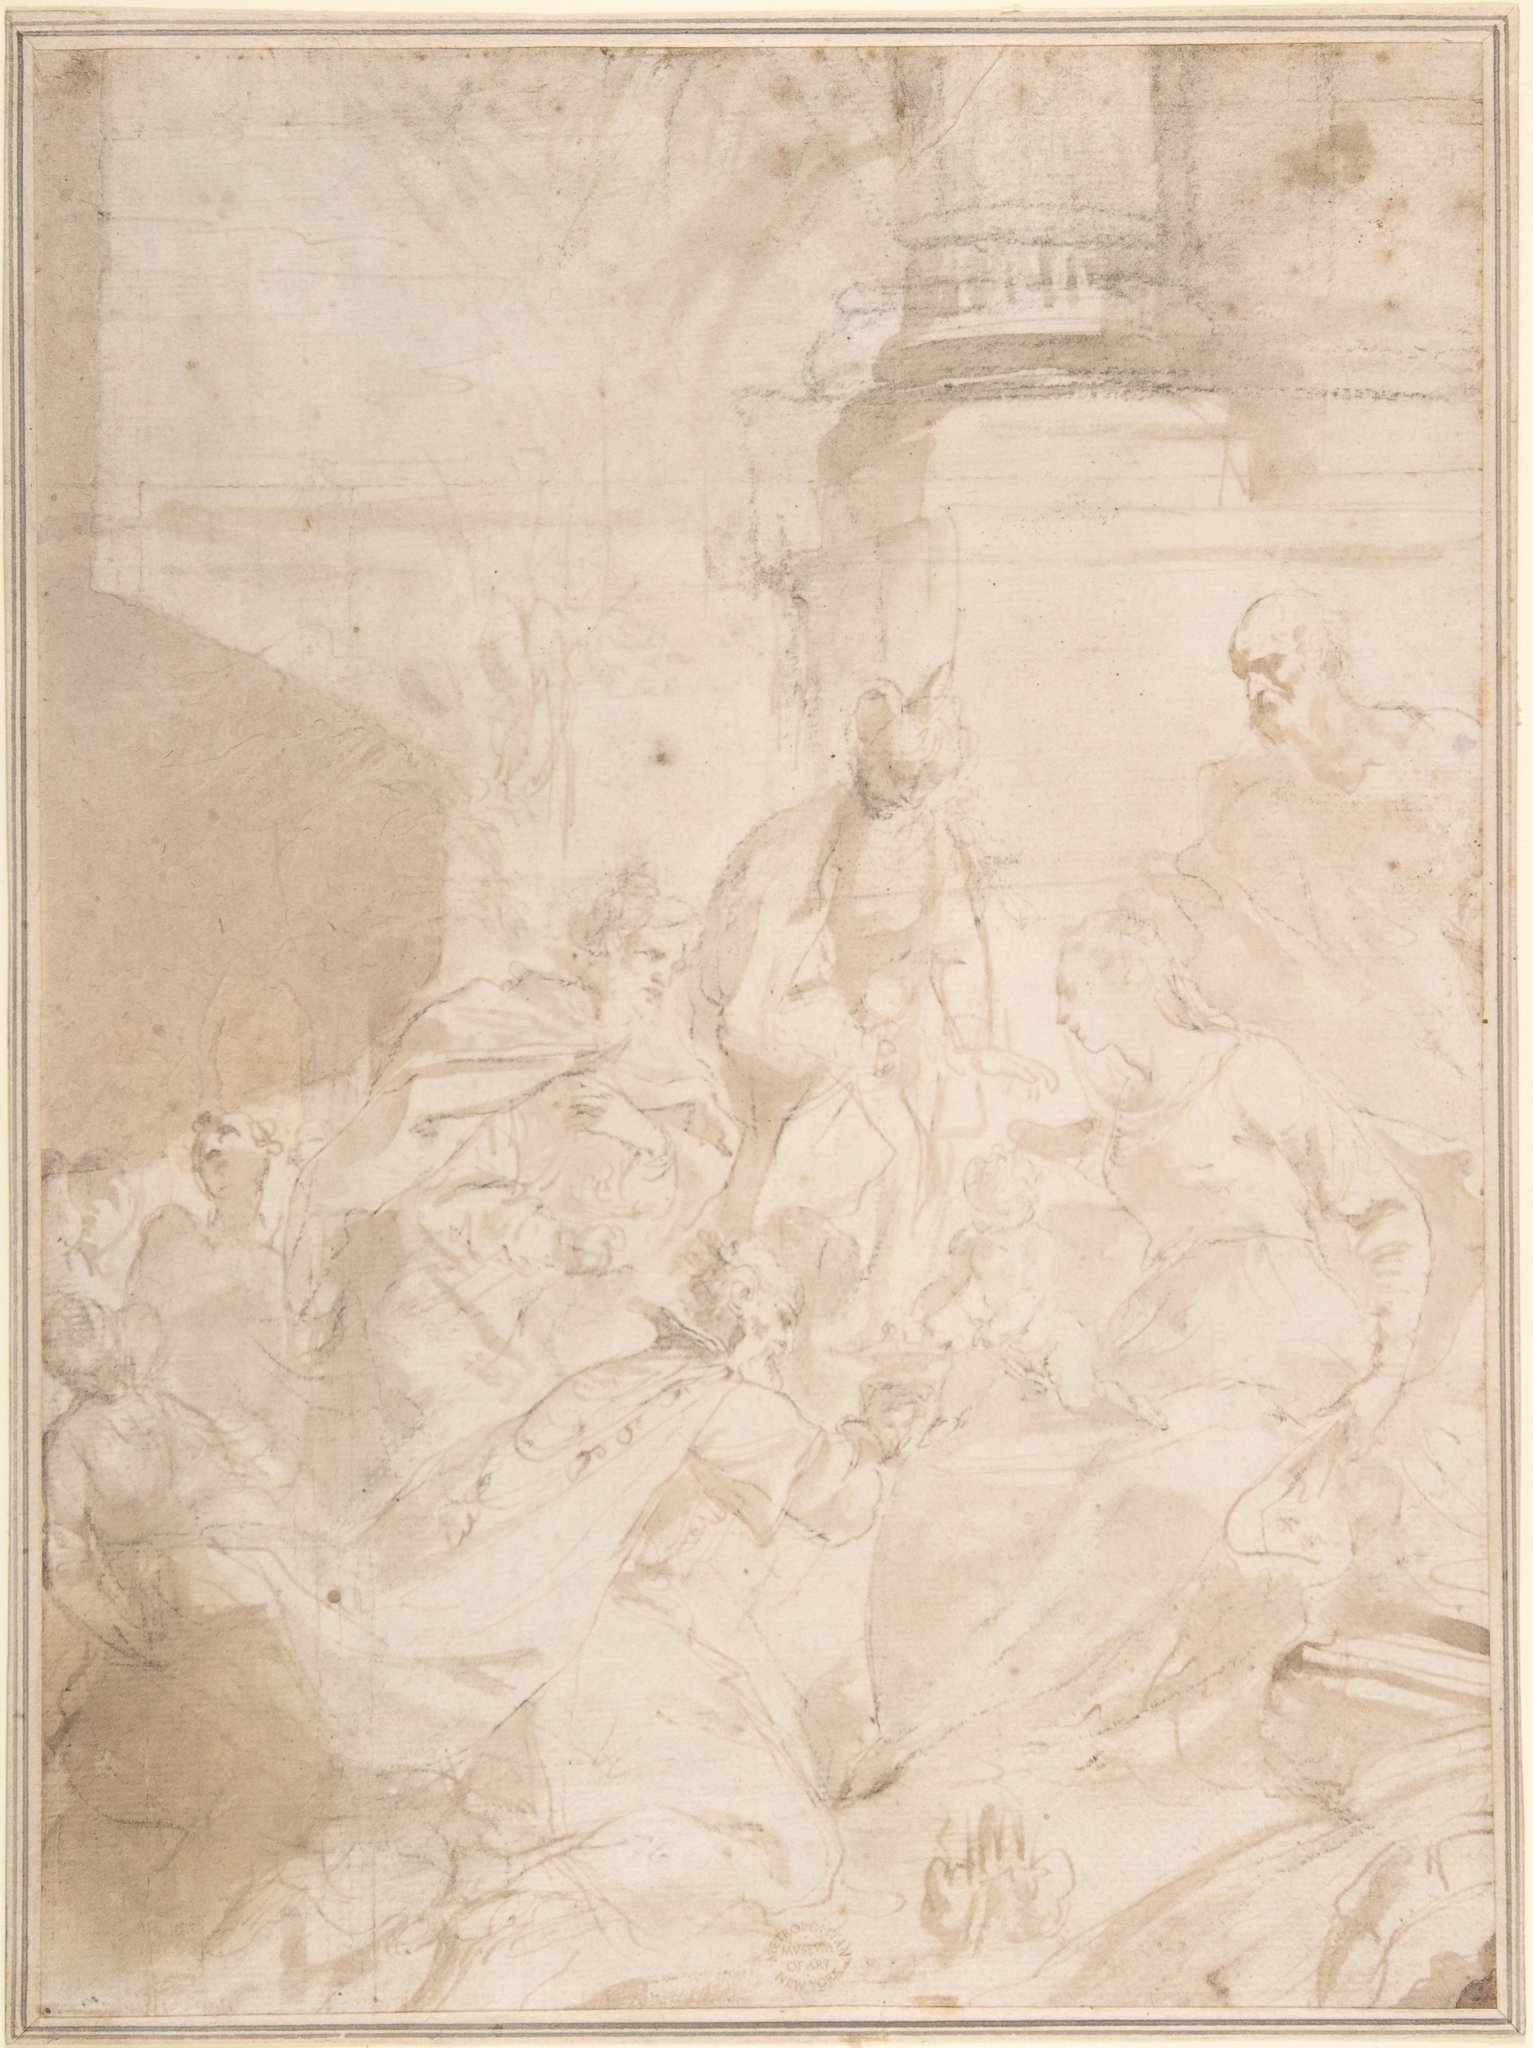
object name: drawing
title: Adoration of the Kings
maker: anonymous, italian, roman-bolognese, 17th century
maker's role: artist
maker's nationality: italian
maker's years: 1600-1700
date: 1601-1700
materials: charcoal, ink, paper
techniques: brush, pen, wash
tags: kings,men,women